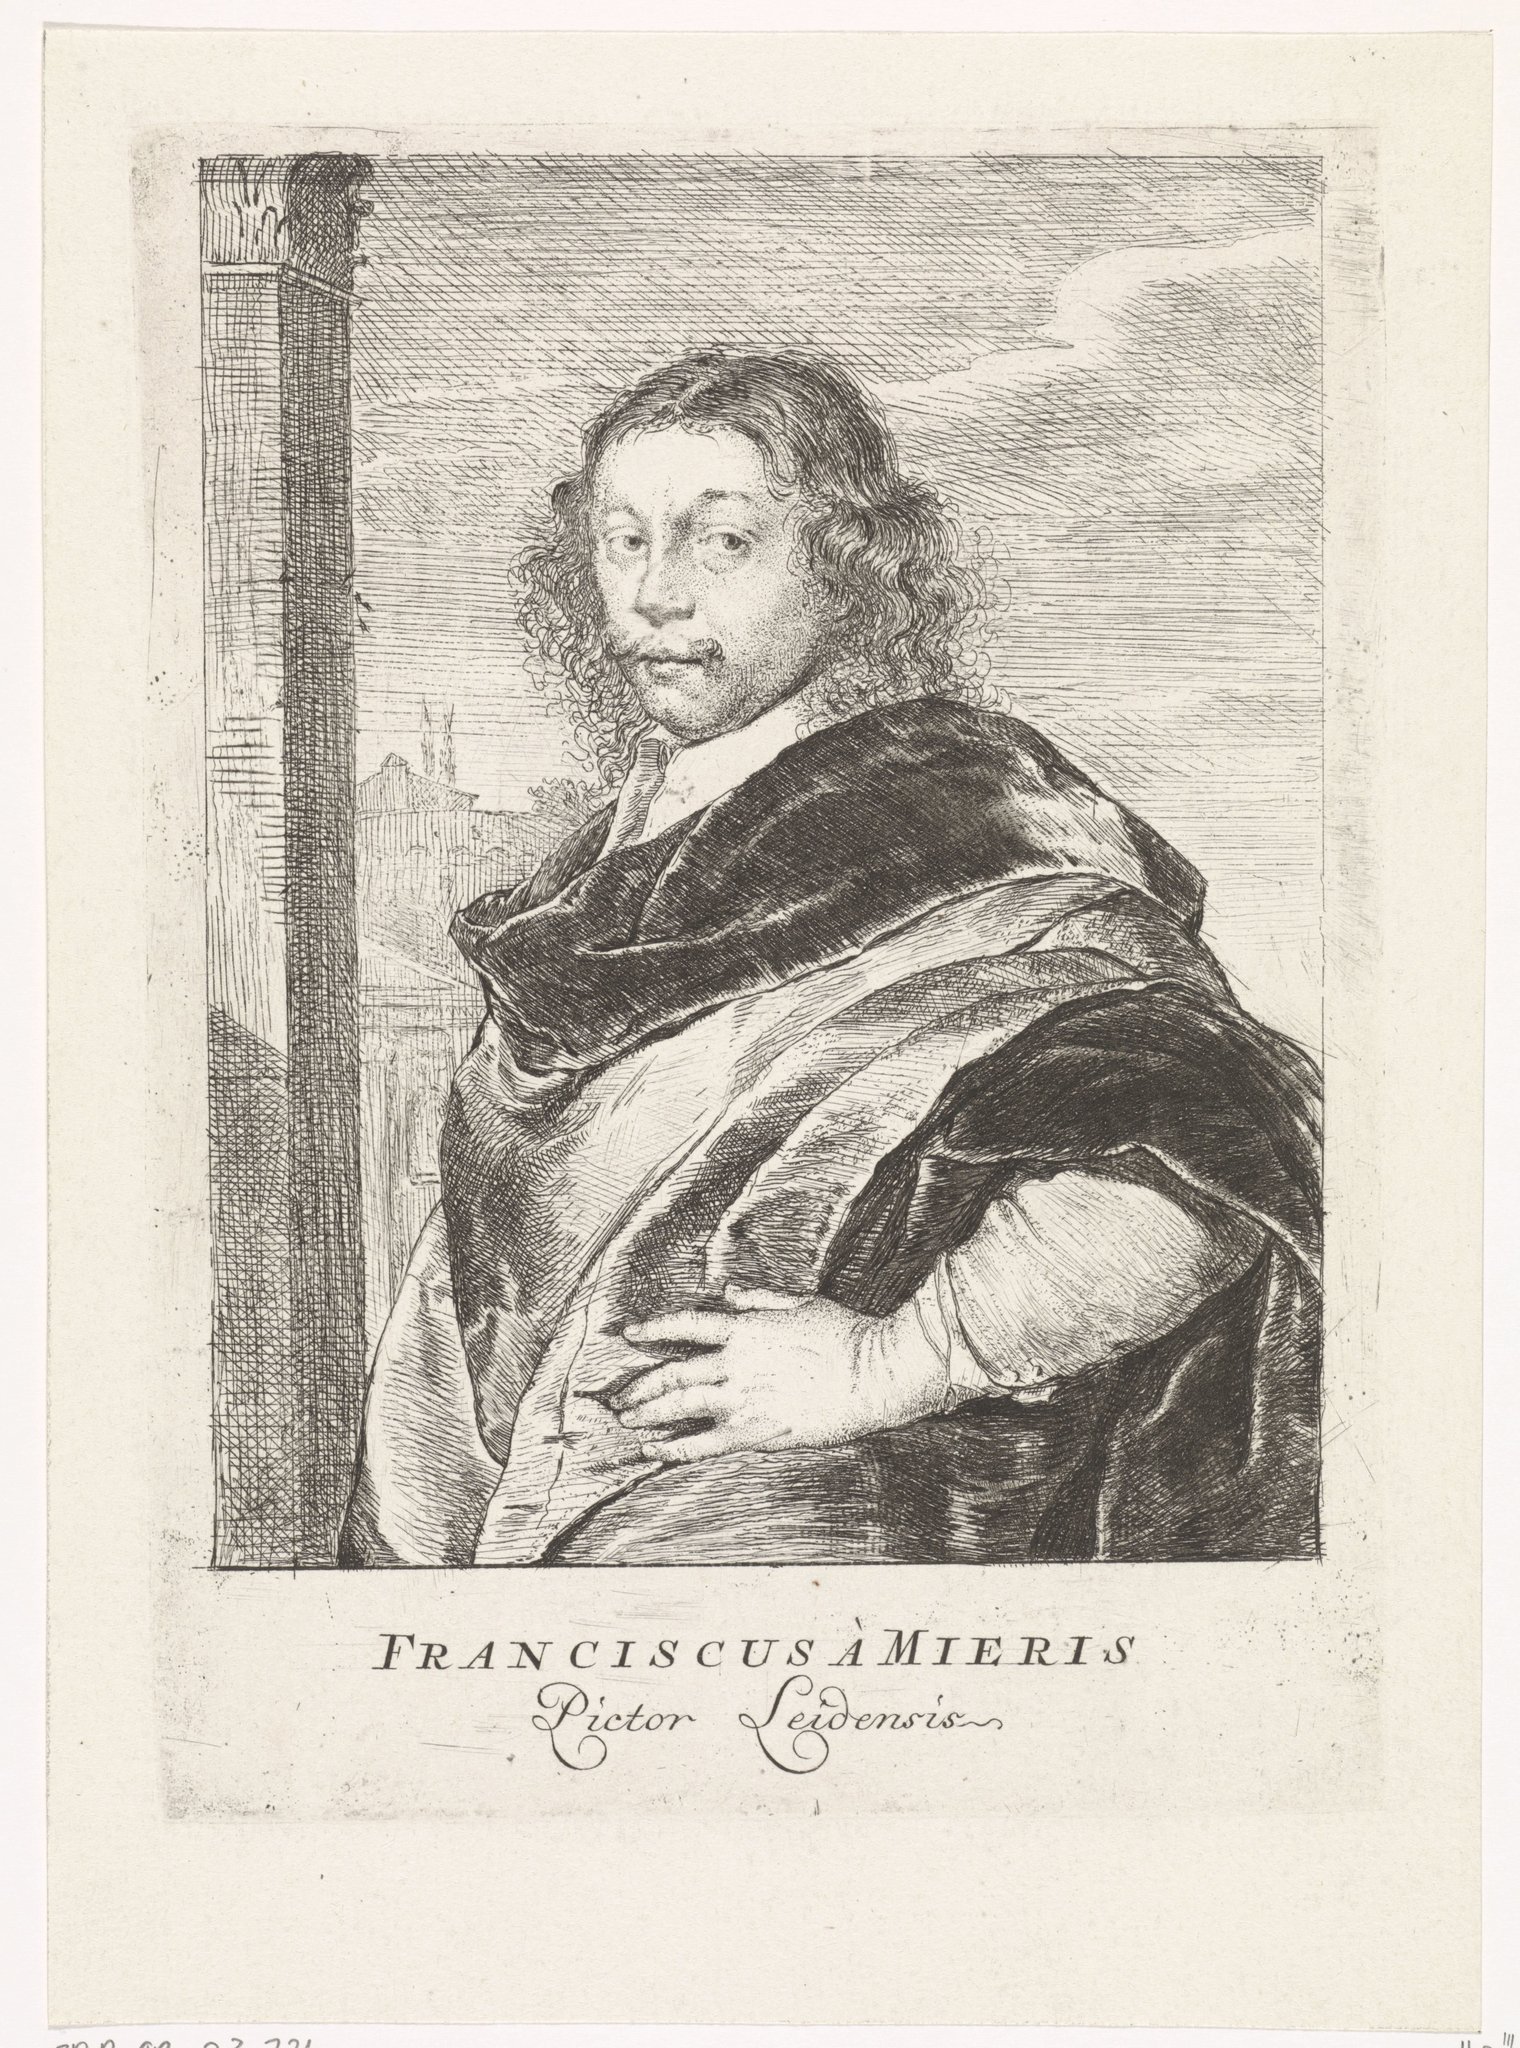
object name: print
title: Portret van Frans van Mieris (I)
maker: carel de moor (ii)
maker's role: draughtsman, painter, print maker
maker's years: 1655-1738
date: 1665-1738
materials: paper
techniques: etching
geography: netherlands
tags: frans van mieris (i), portrait, self-portrait of painter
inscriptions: collector's mark: Lugt 240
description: Portret van de Leidse schilder Frans van Mieris (I).